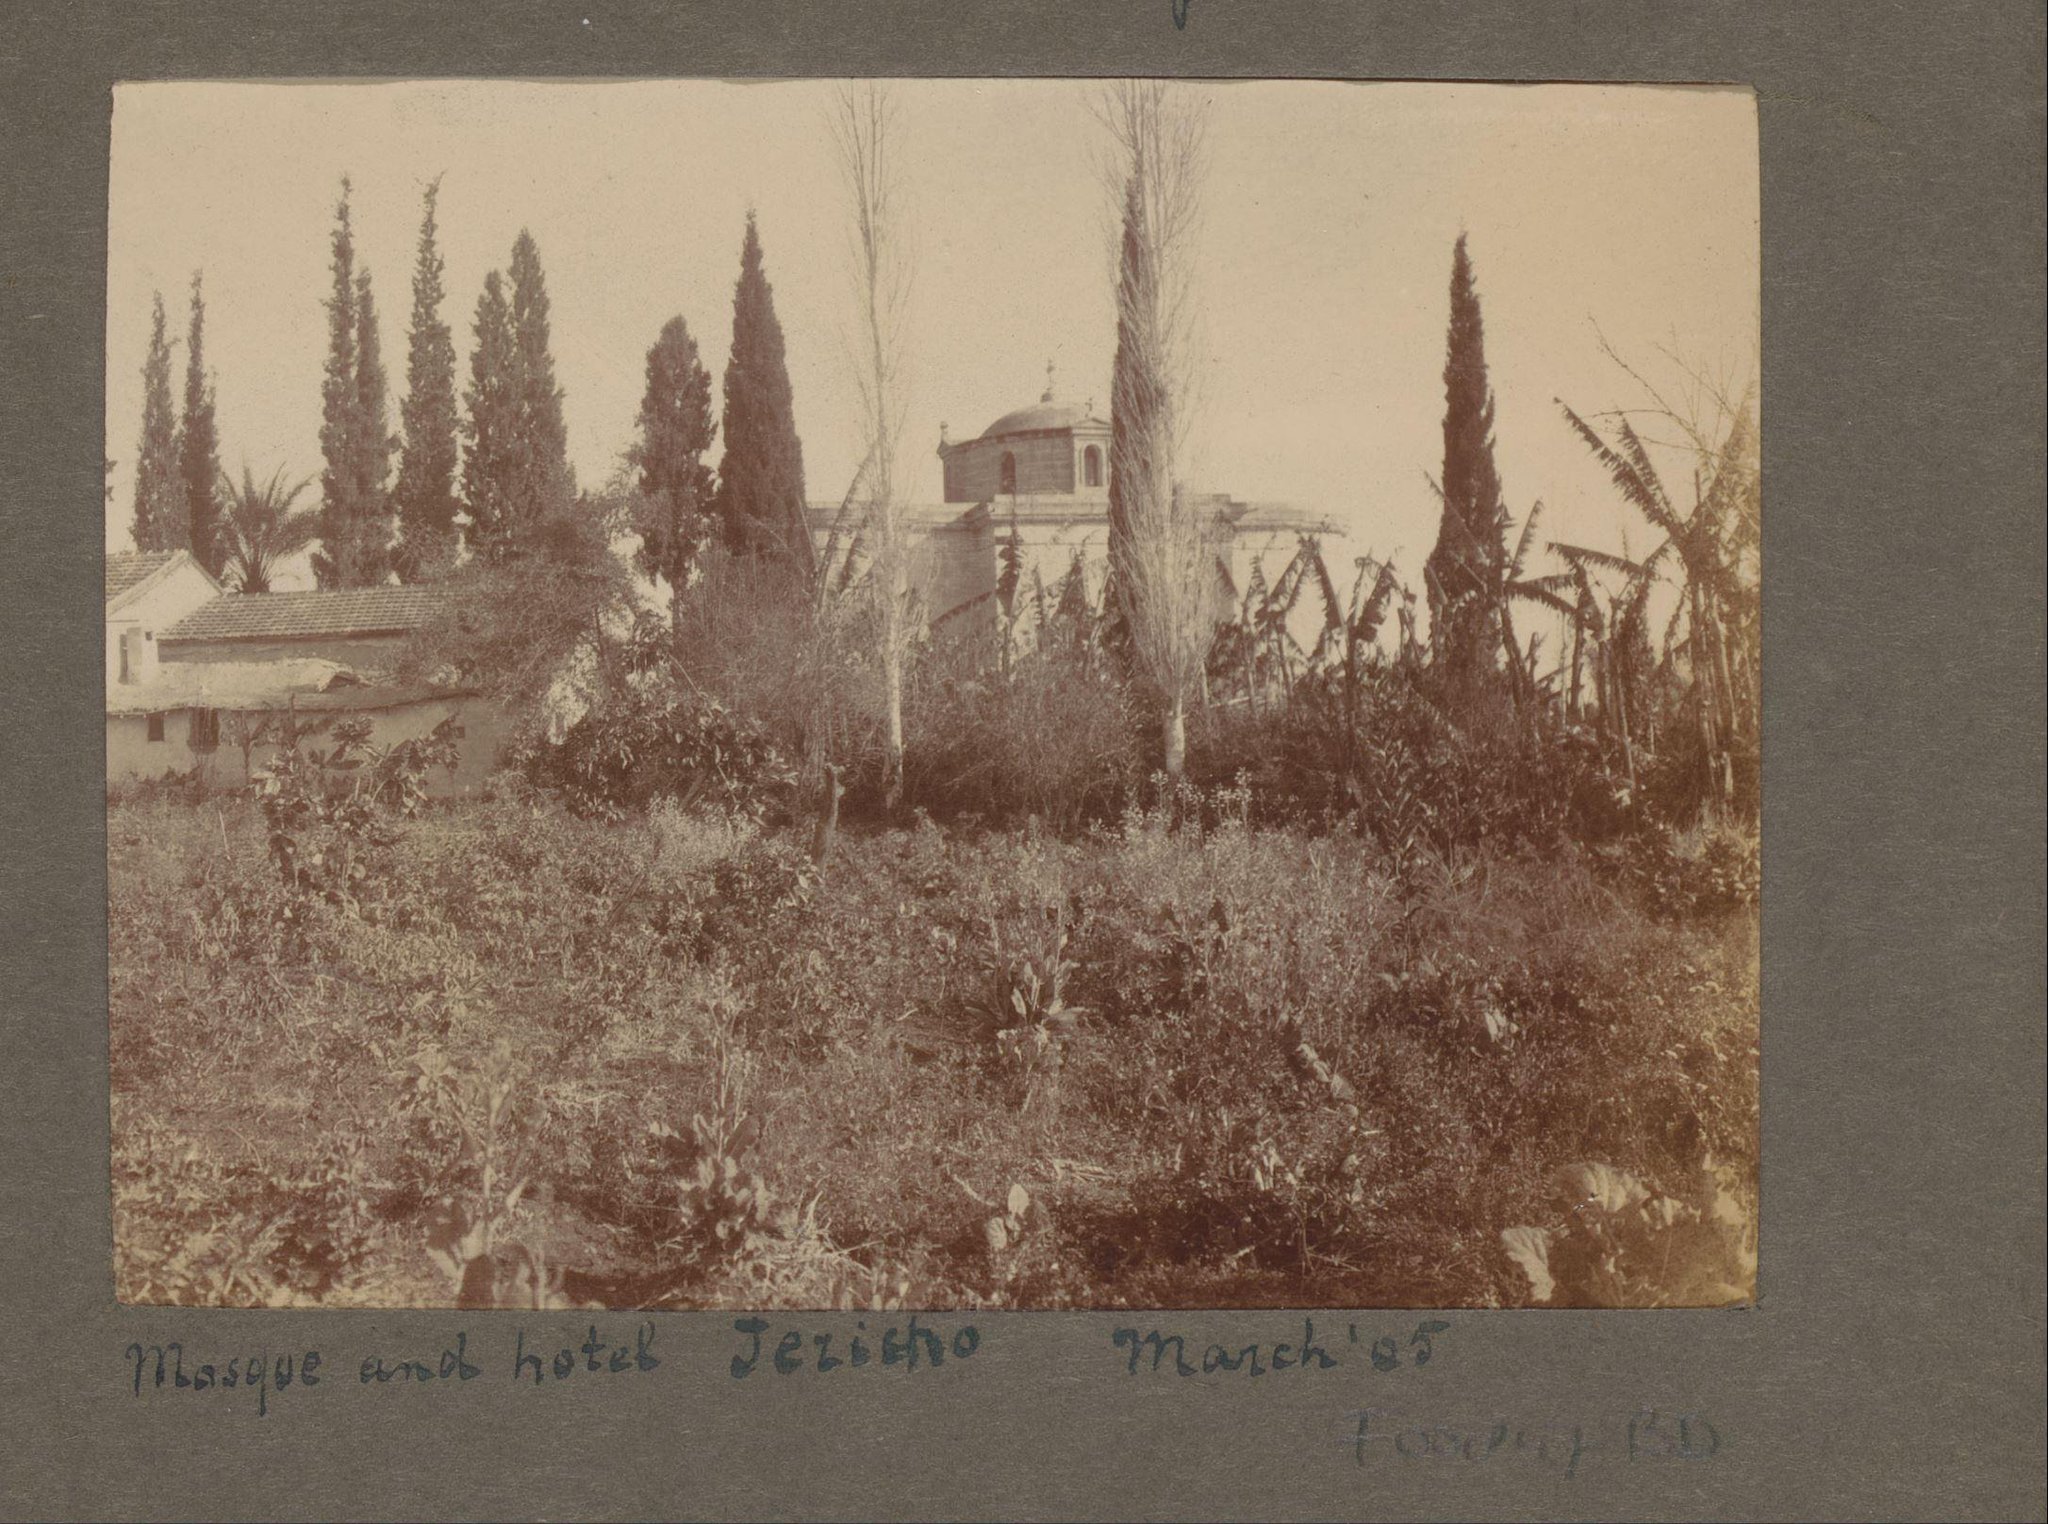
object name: album leaf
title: Veld met op de achtergrond een moskee en een hotel in Jericho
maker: Anonymous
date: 1903-1905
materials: cardboard, paper, photographic support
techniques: gelatin silver print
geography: jericho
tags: temple, shrine ~ islam, mohammedanism, hotel, hostelry, inn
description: Onderdeel van Reisalbum van een Nederlandse familie met bezienswaardigheden in Europa, Egypte en New York.